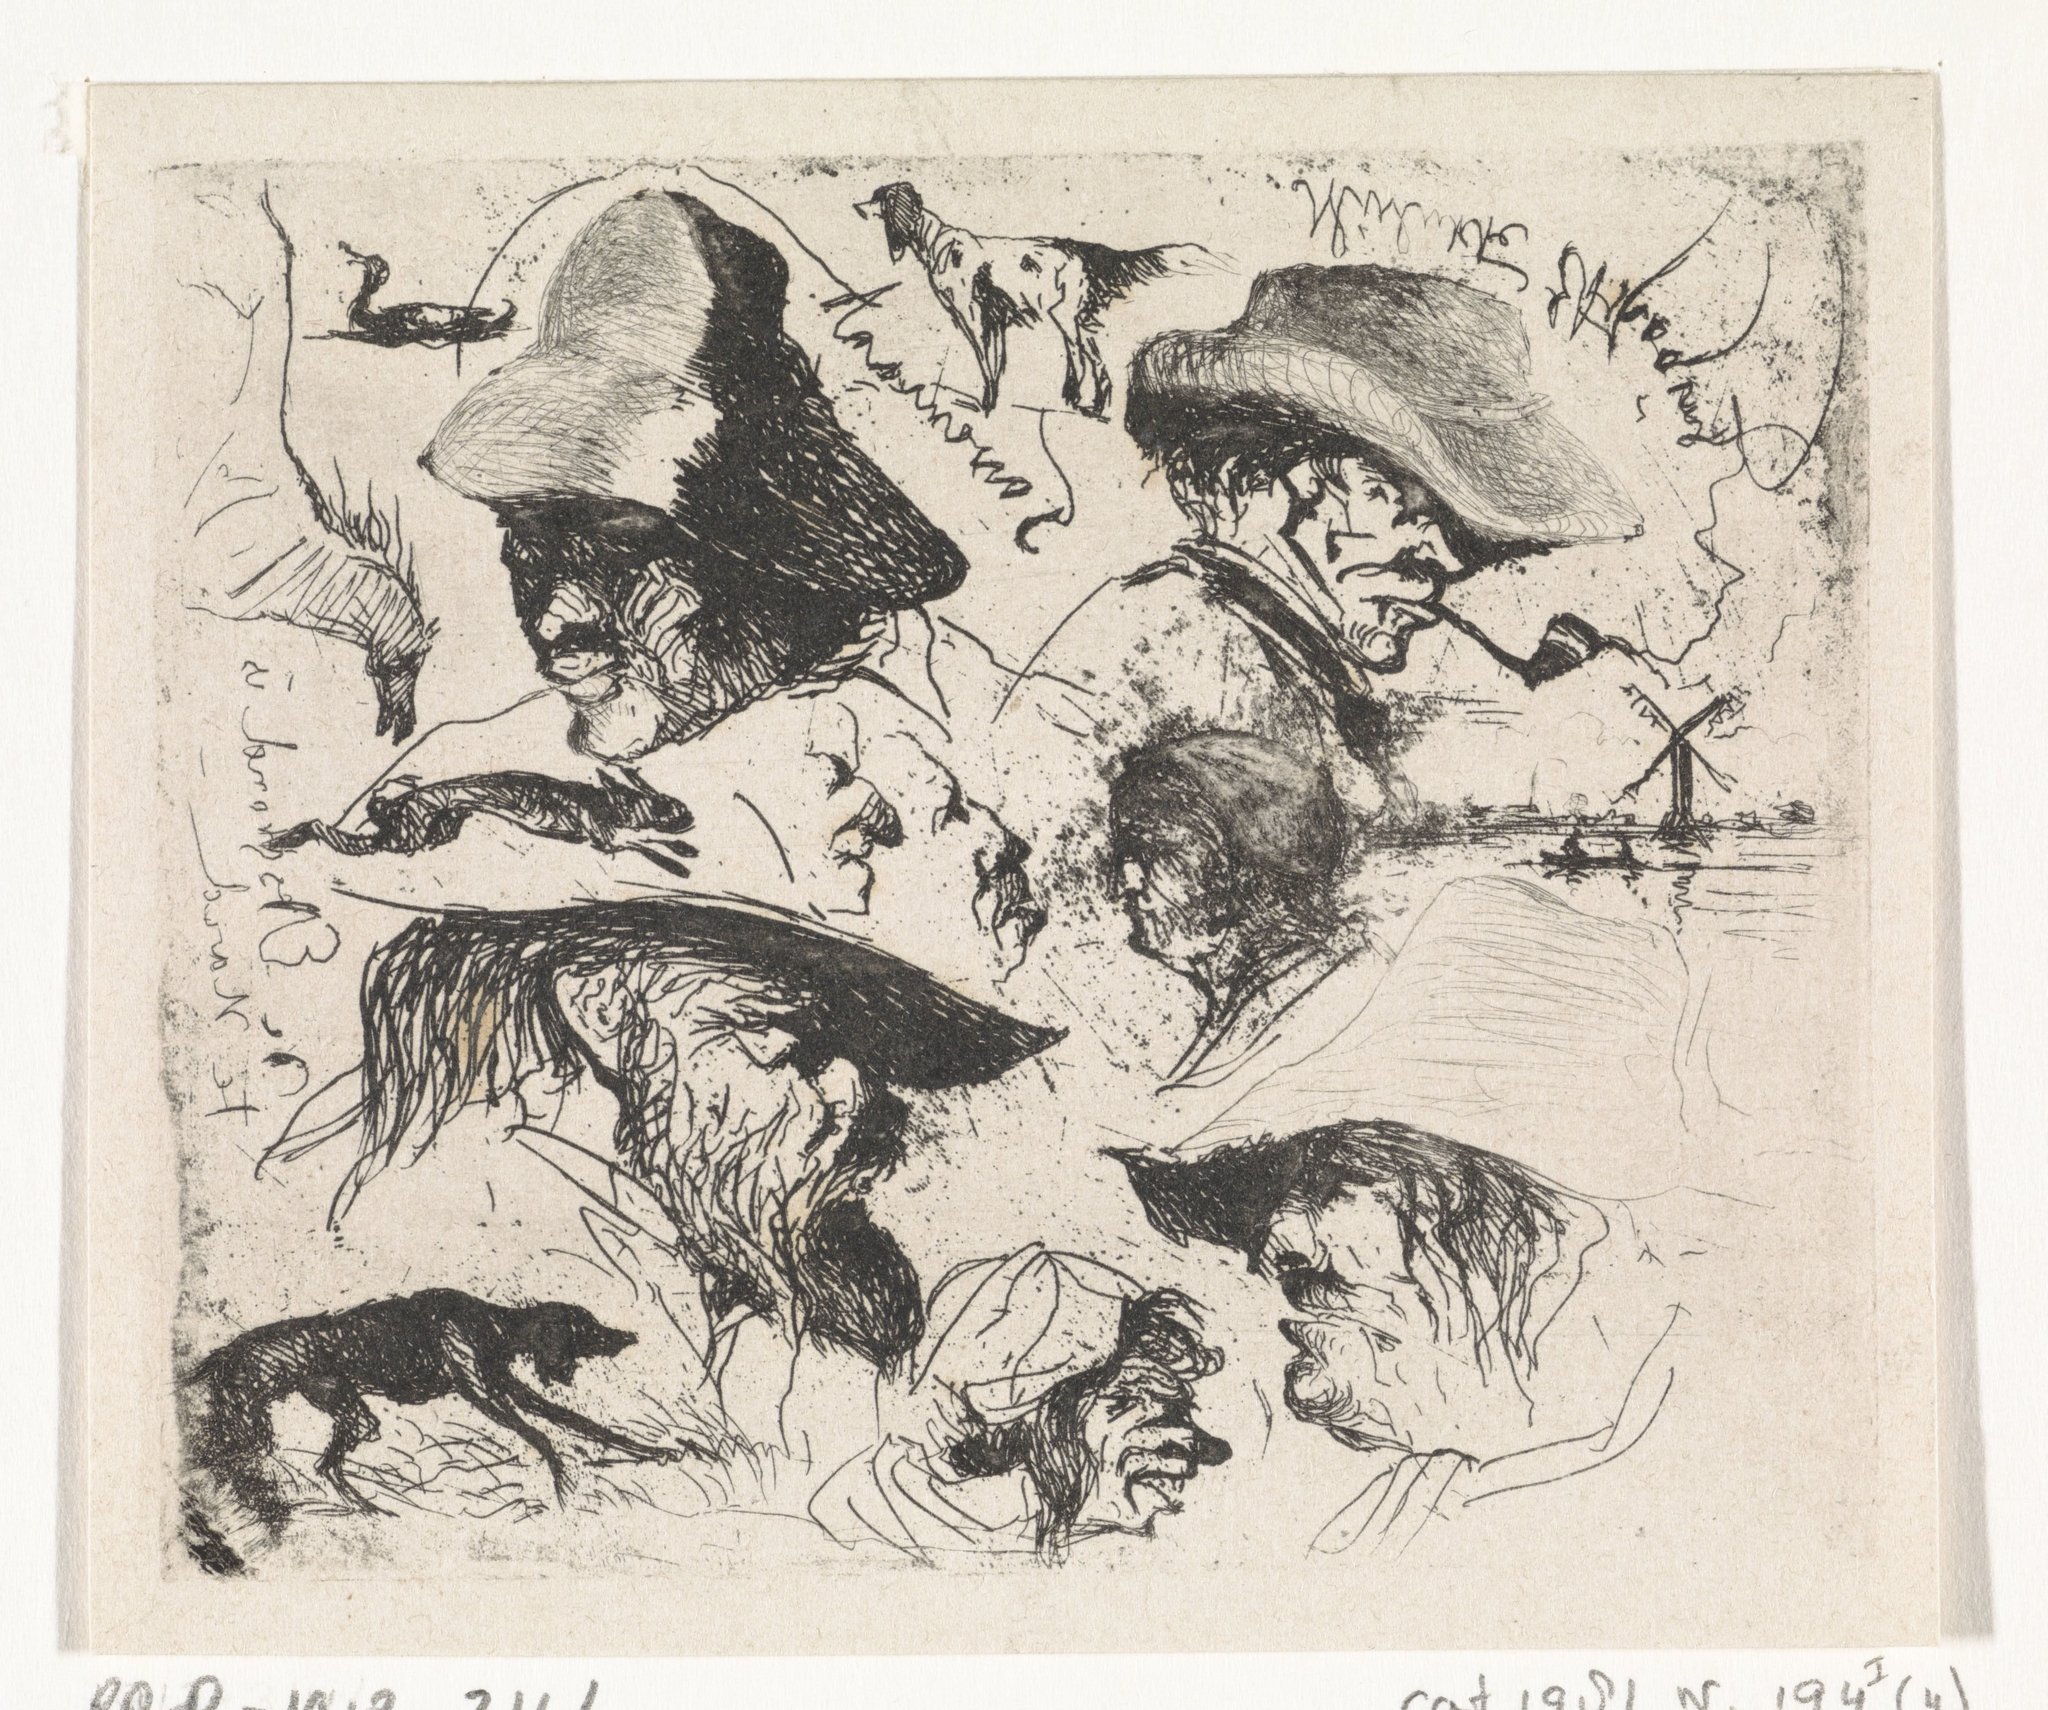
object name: print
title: Allerlei bij avond gemaakt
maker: johannes tavenraat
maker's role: draughtsman, painter, print maker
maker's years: 1809-1881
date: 1819-1881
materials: paper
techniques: etching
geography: cleves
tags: head-gear: hat (+ men's clothes), windmill, dog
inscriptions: collector's mark: Lugt 2228, inscription: ‘Mislukte etspoging / De Etsgrond is te hard’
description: Studieblad met verschillende mannengezichten met hoofddeksels. Linksonder een hond. Midden rechts een molen aan het water.